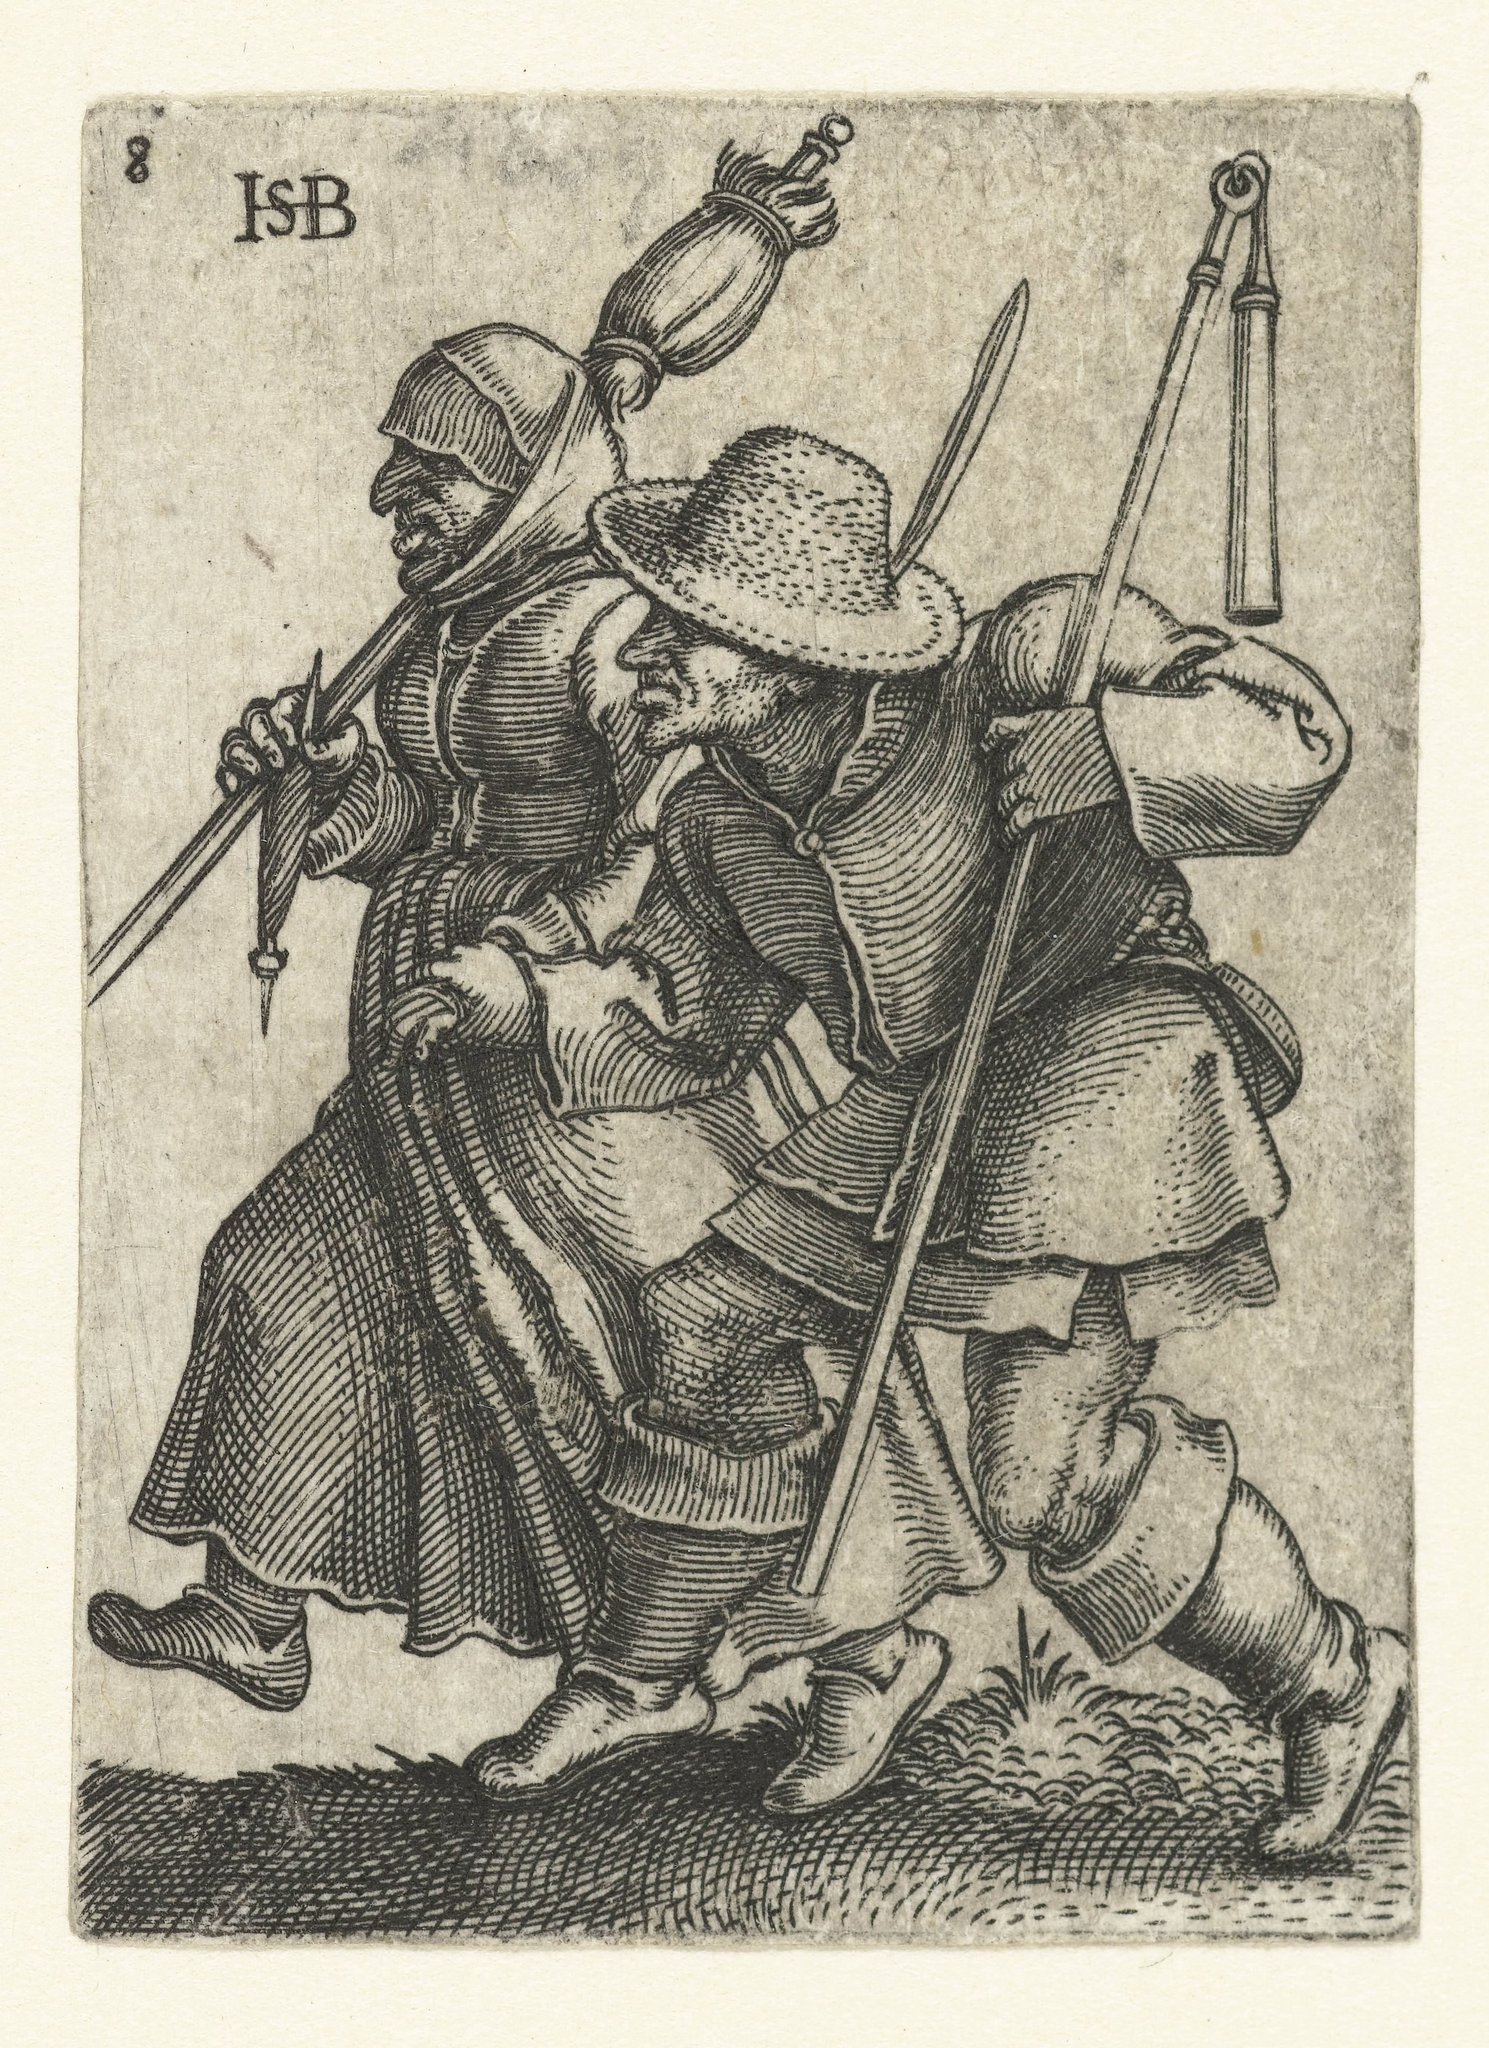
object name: print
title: Boerenfeest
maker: hans sebald beham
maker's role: designer, draughtsman, print maker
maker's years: 1500-1550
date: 1537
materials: paper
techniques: engraving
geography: frankfurt am main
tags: (annual) fair, trade fair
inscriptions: collector's mark: Lugt 2228a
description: Dansend boerenpaar, hij met een dorsvlegel in de hand en zij met een spinrokken.